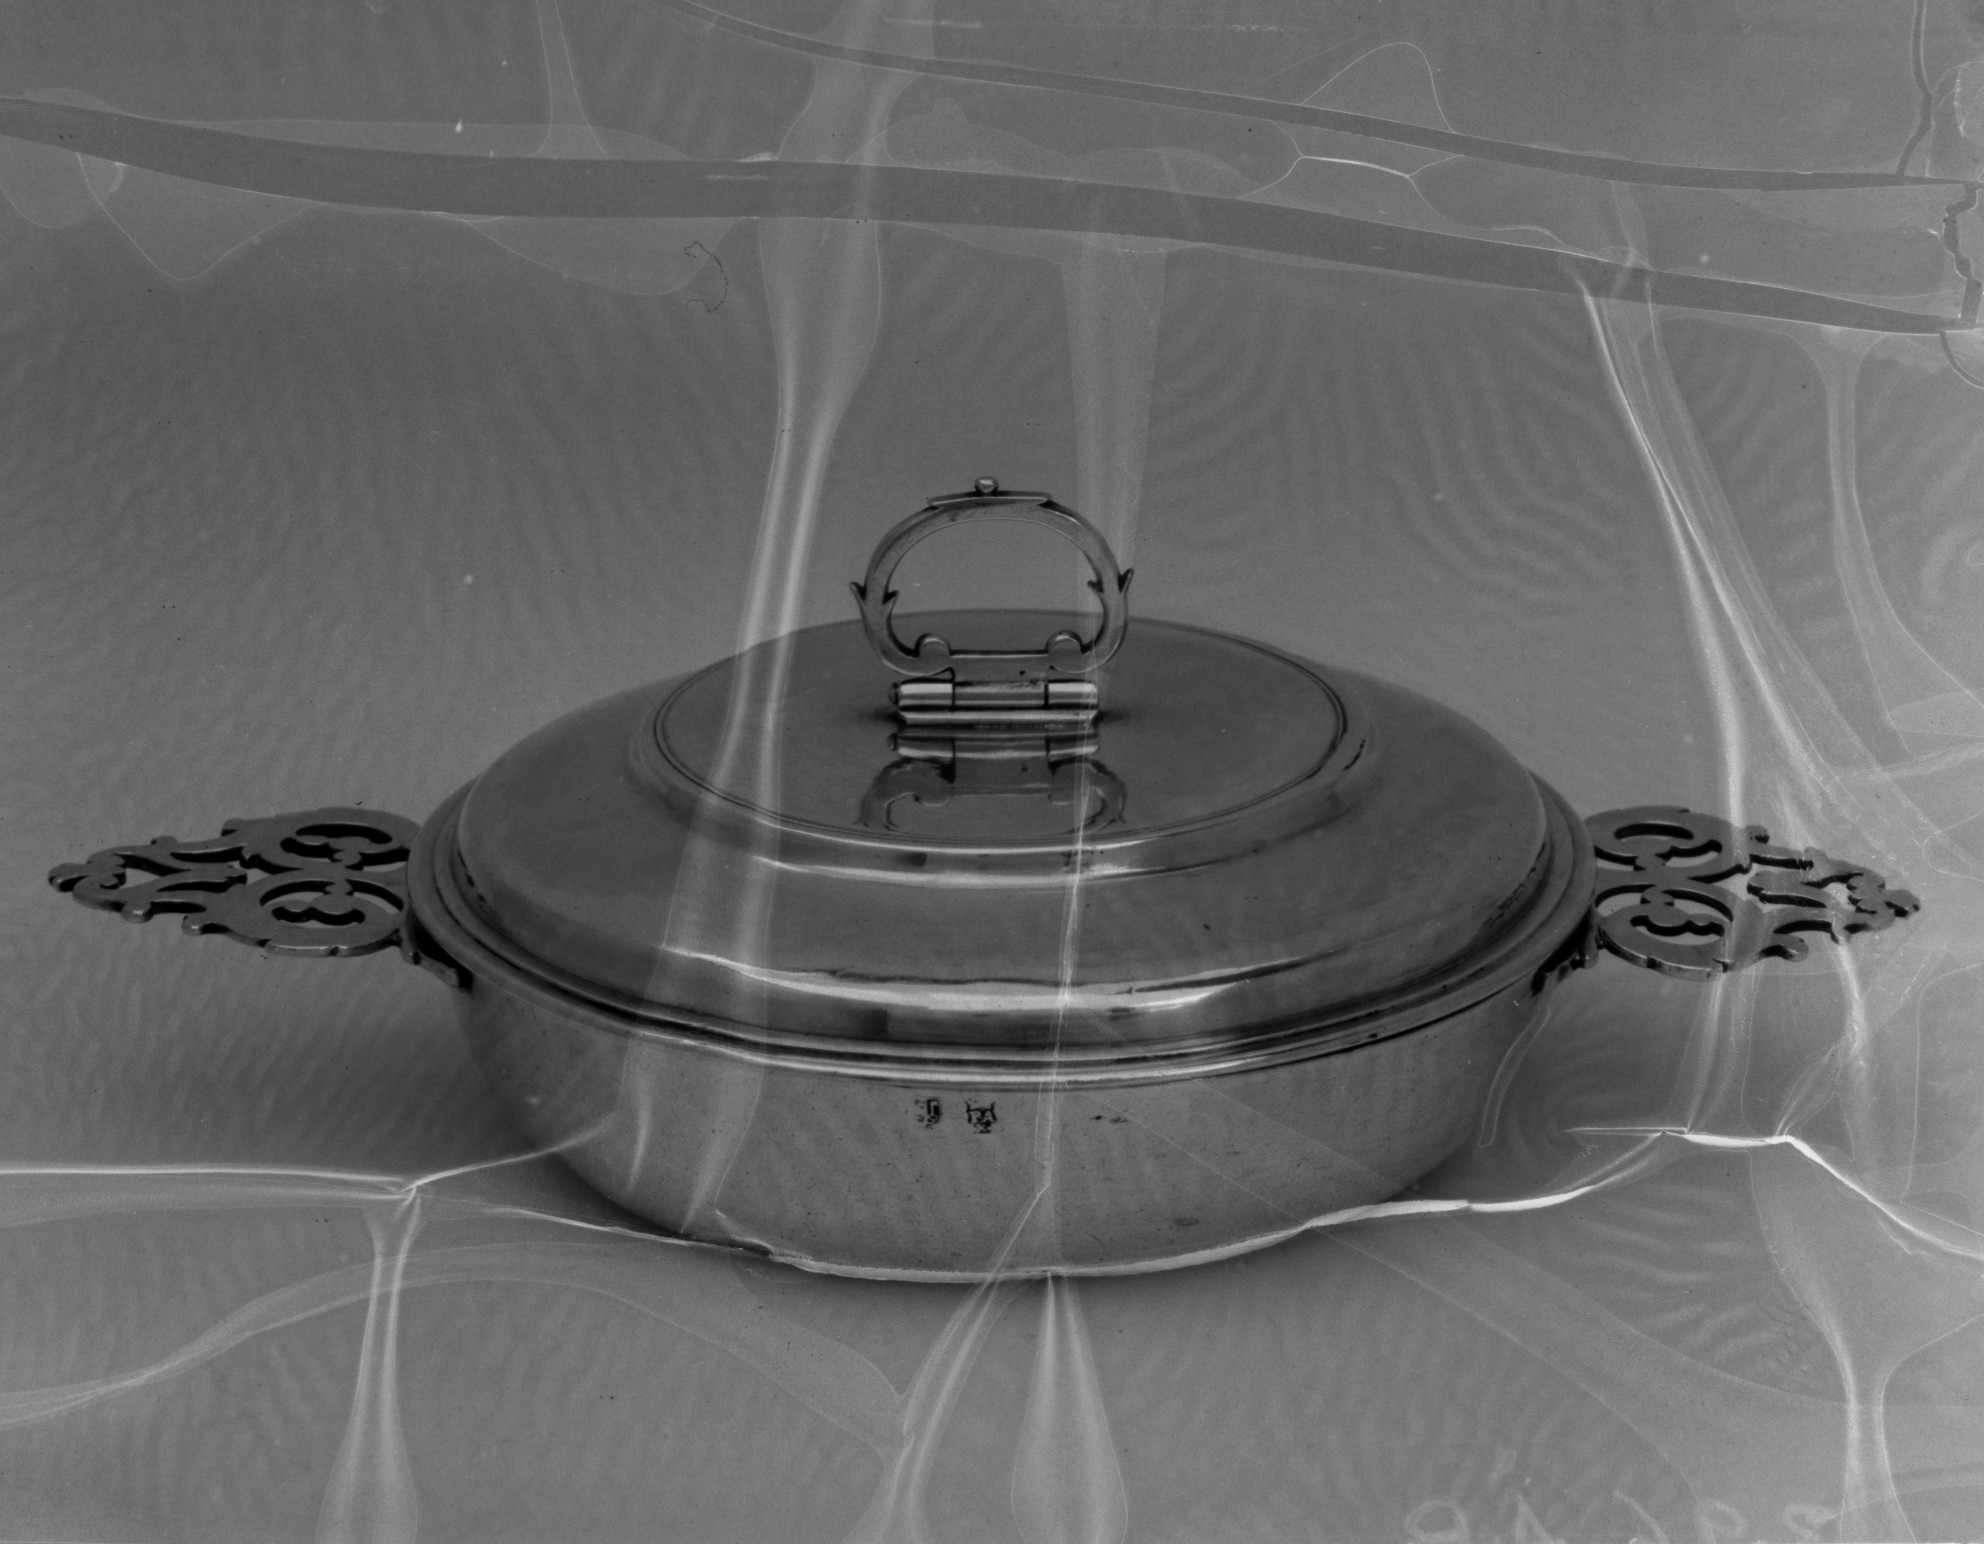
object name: dish with cover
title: Dish with cover (Écuelle)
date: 1667-1733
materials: silver